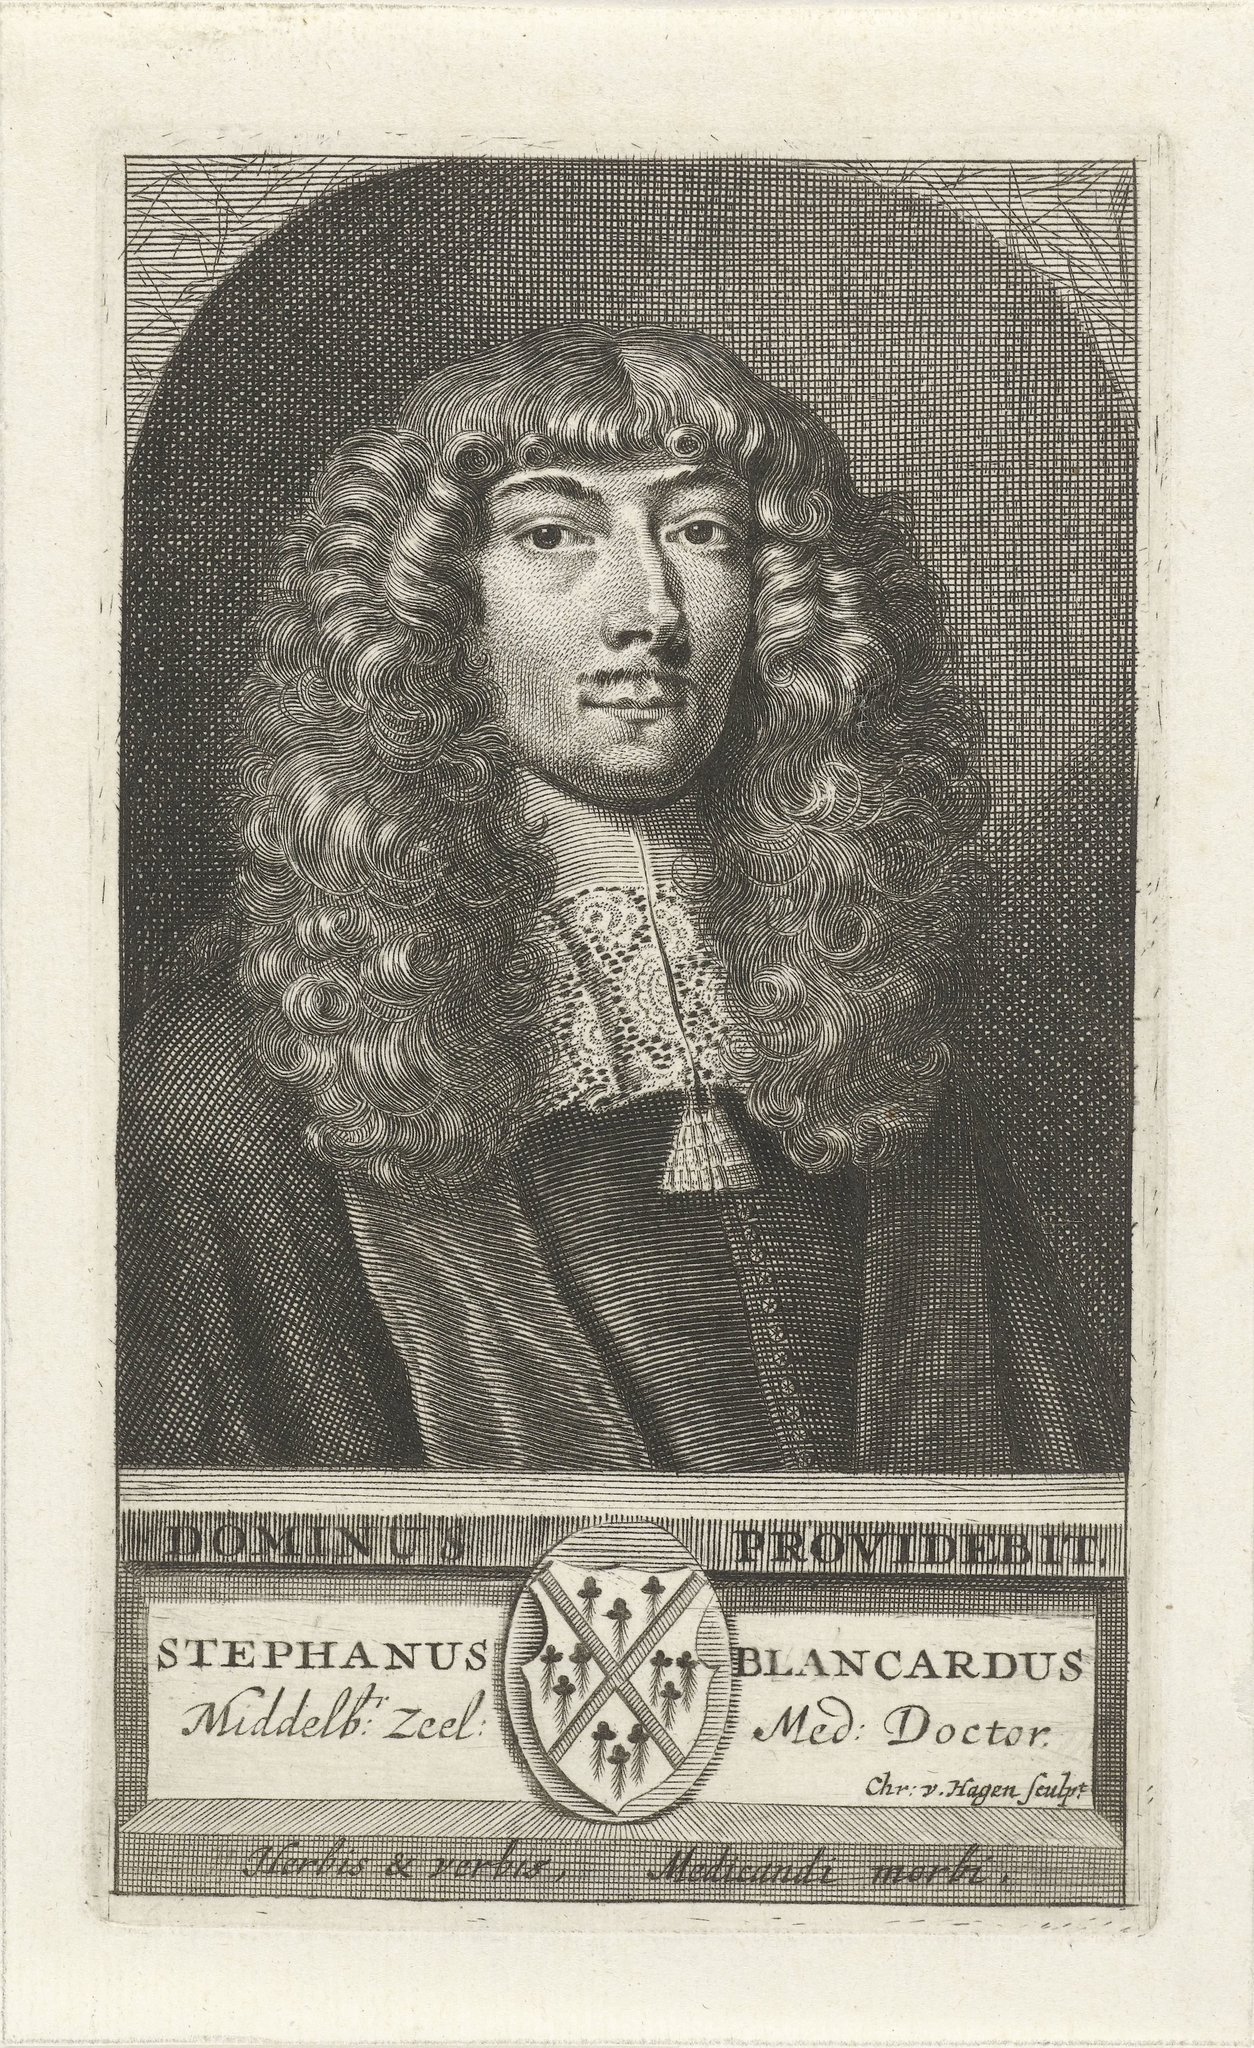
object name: print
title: Portret van Steven Blankaart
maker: christiaan hagen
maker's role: draughtsman, print maker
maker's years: 1635-1707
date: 1663-1695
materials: paper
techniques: engraving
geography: amsterdam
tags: middelburg, moustache, styles of hairdress, lace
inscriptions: collector's mark: Lugt 2228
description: Buste naar rechts van de arts Steven Blankaart. Onder zijn portret een plint met zijn naam en een familiewapen.